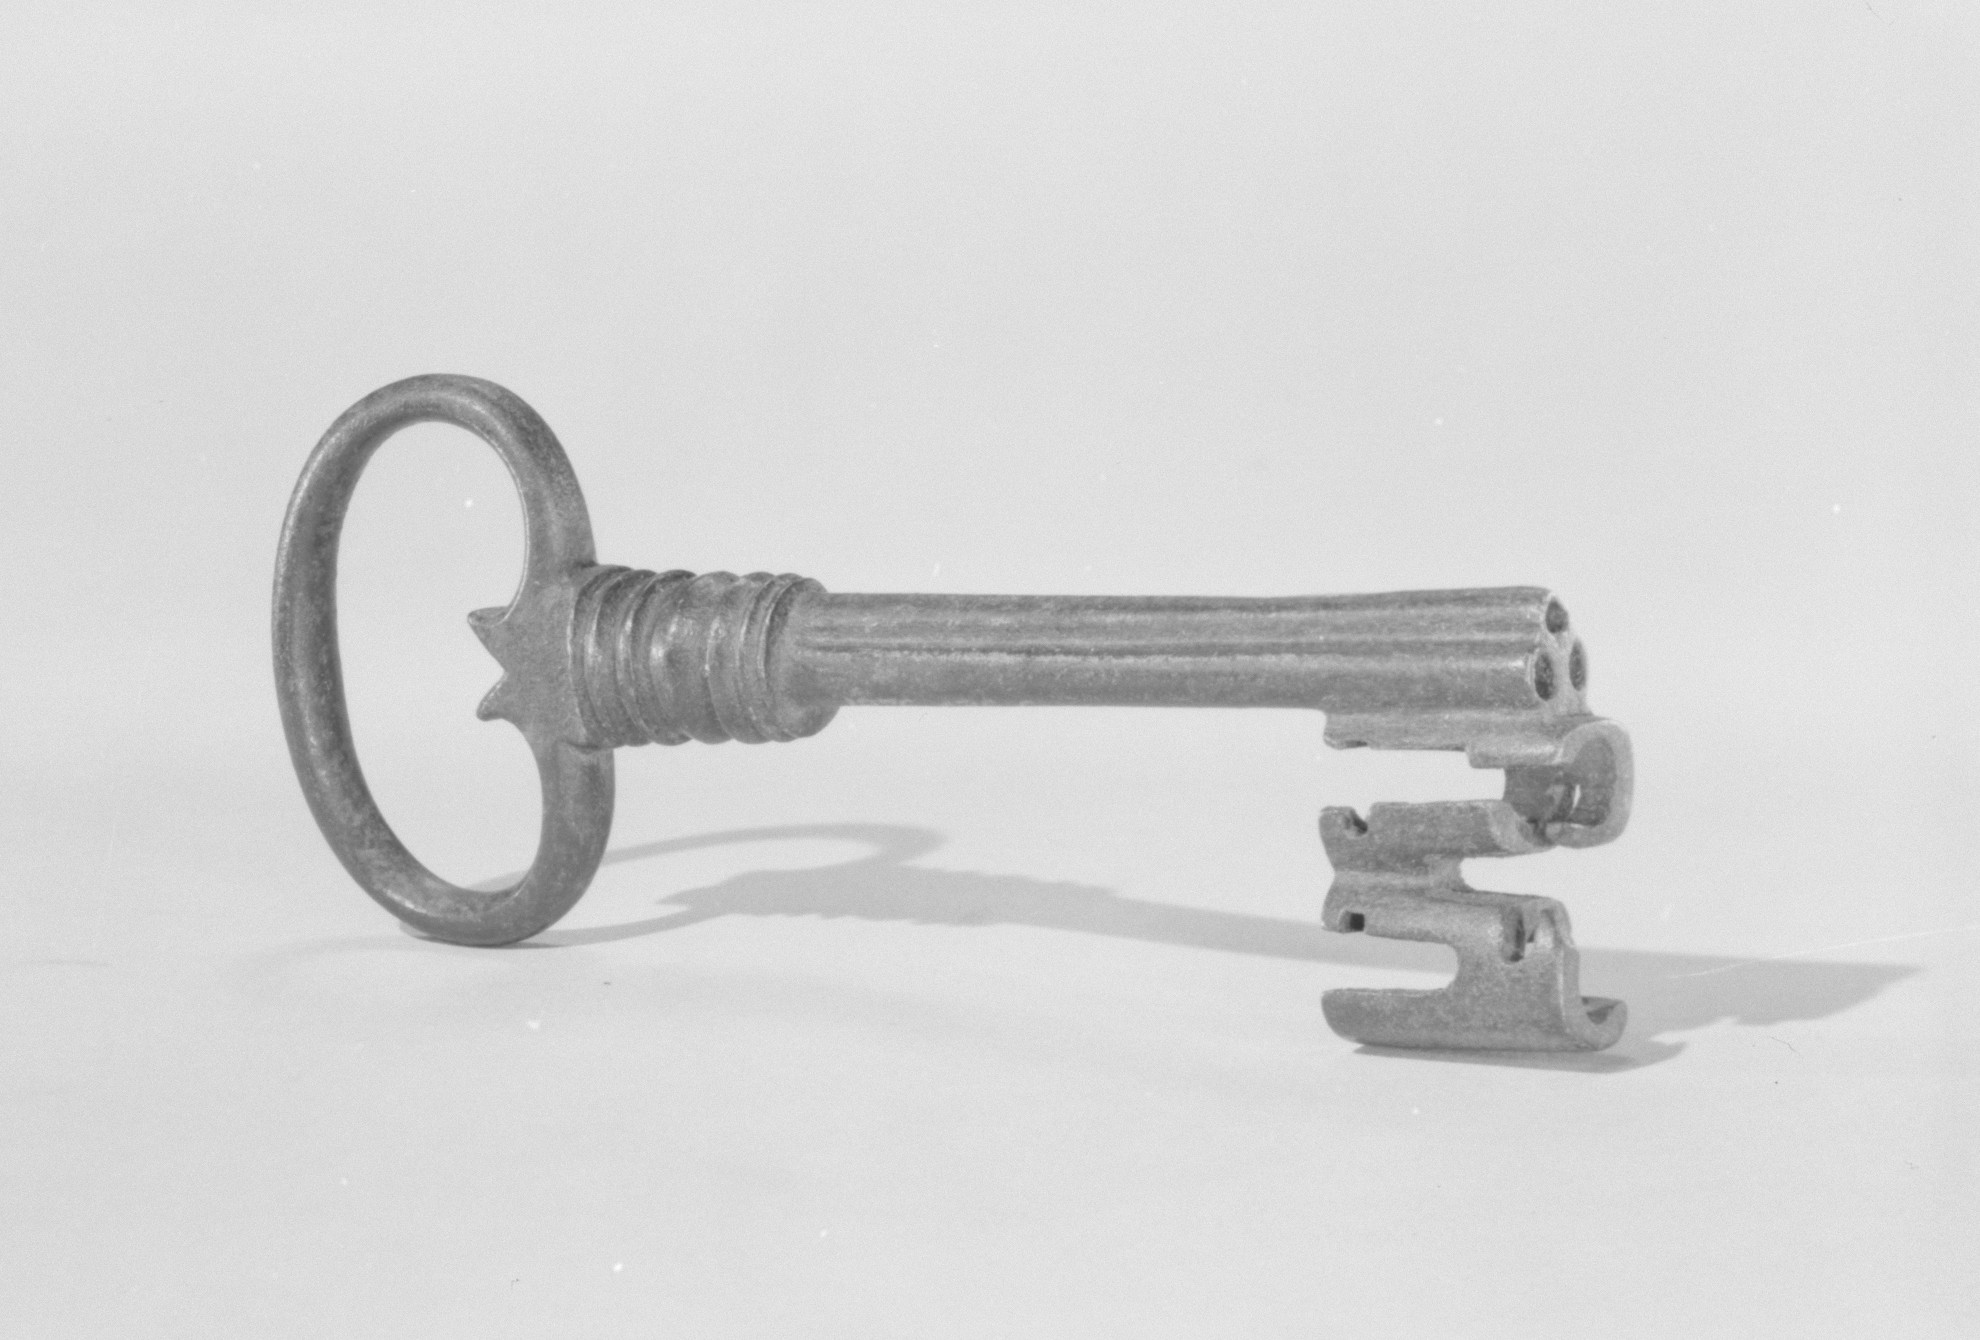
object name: coffer or chest key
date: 1601-1700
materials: iron